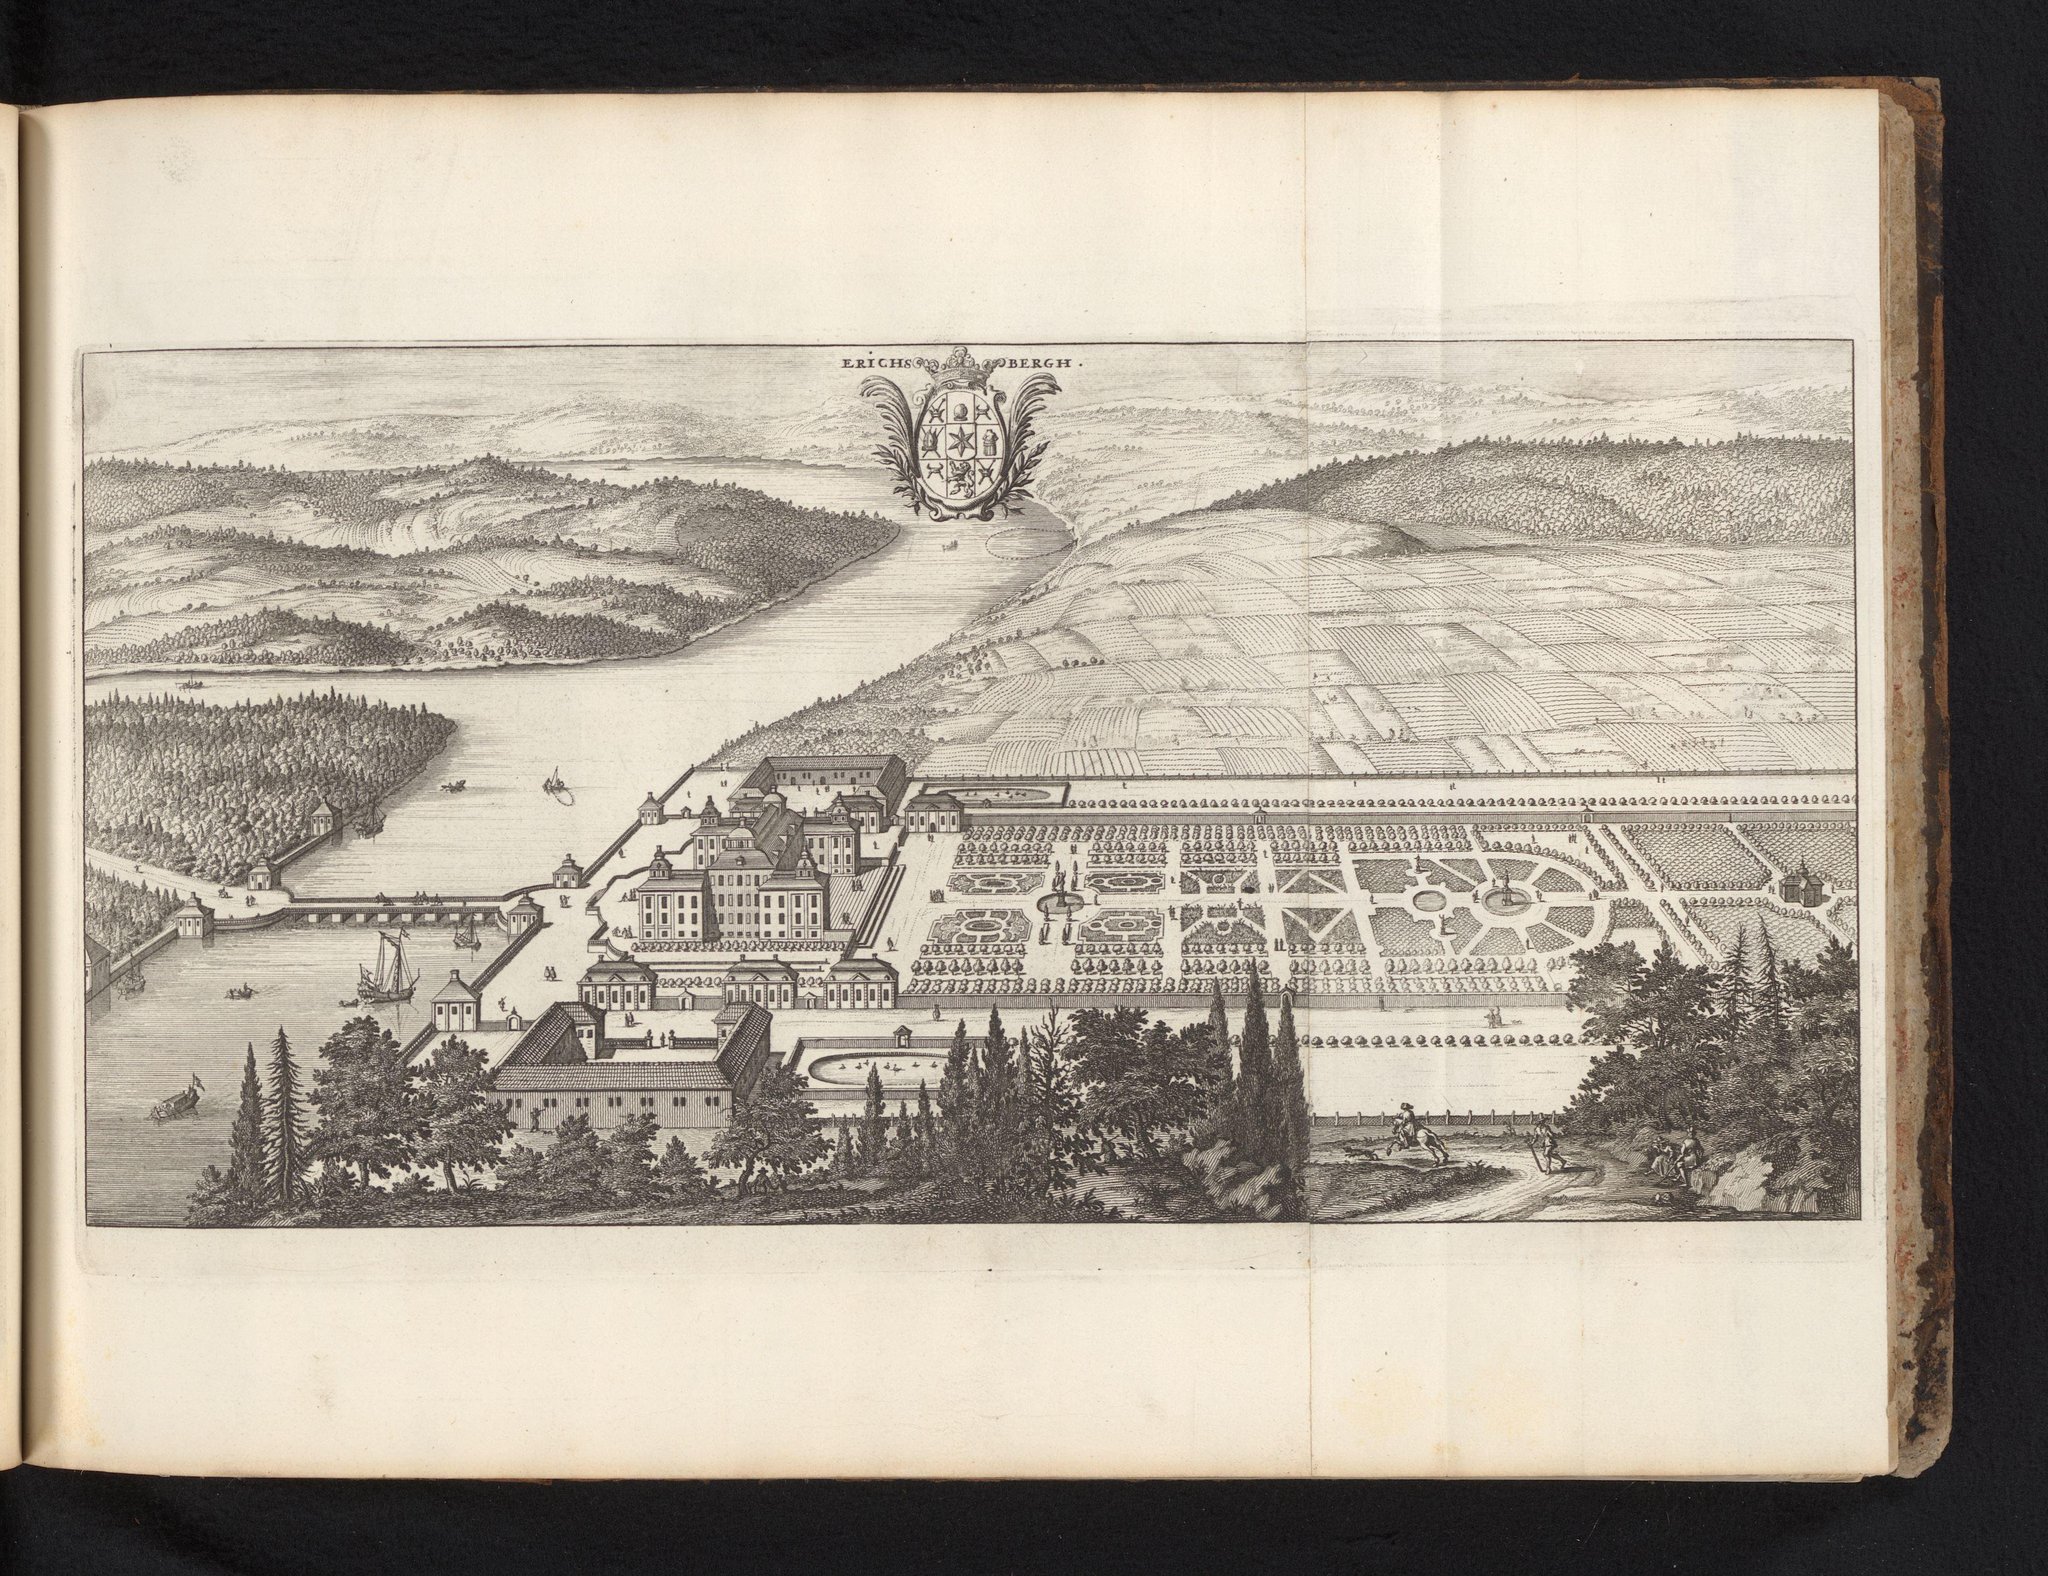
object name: album leaf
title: Suecia Antiqua et Hodierna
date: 1694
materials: paper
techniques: etching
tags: housing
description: Kungliga Biblioteket, 'Suecia': http://www.kb.se/samlingarna/Kartor-bilder/Suecia-antiqua/ (geraadpleegd november 2016).